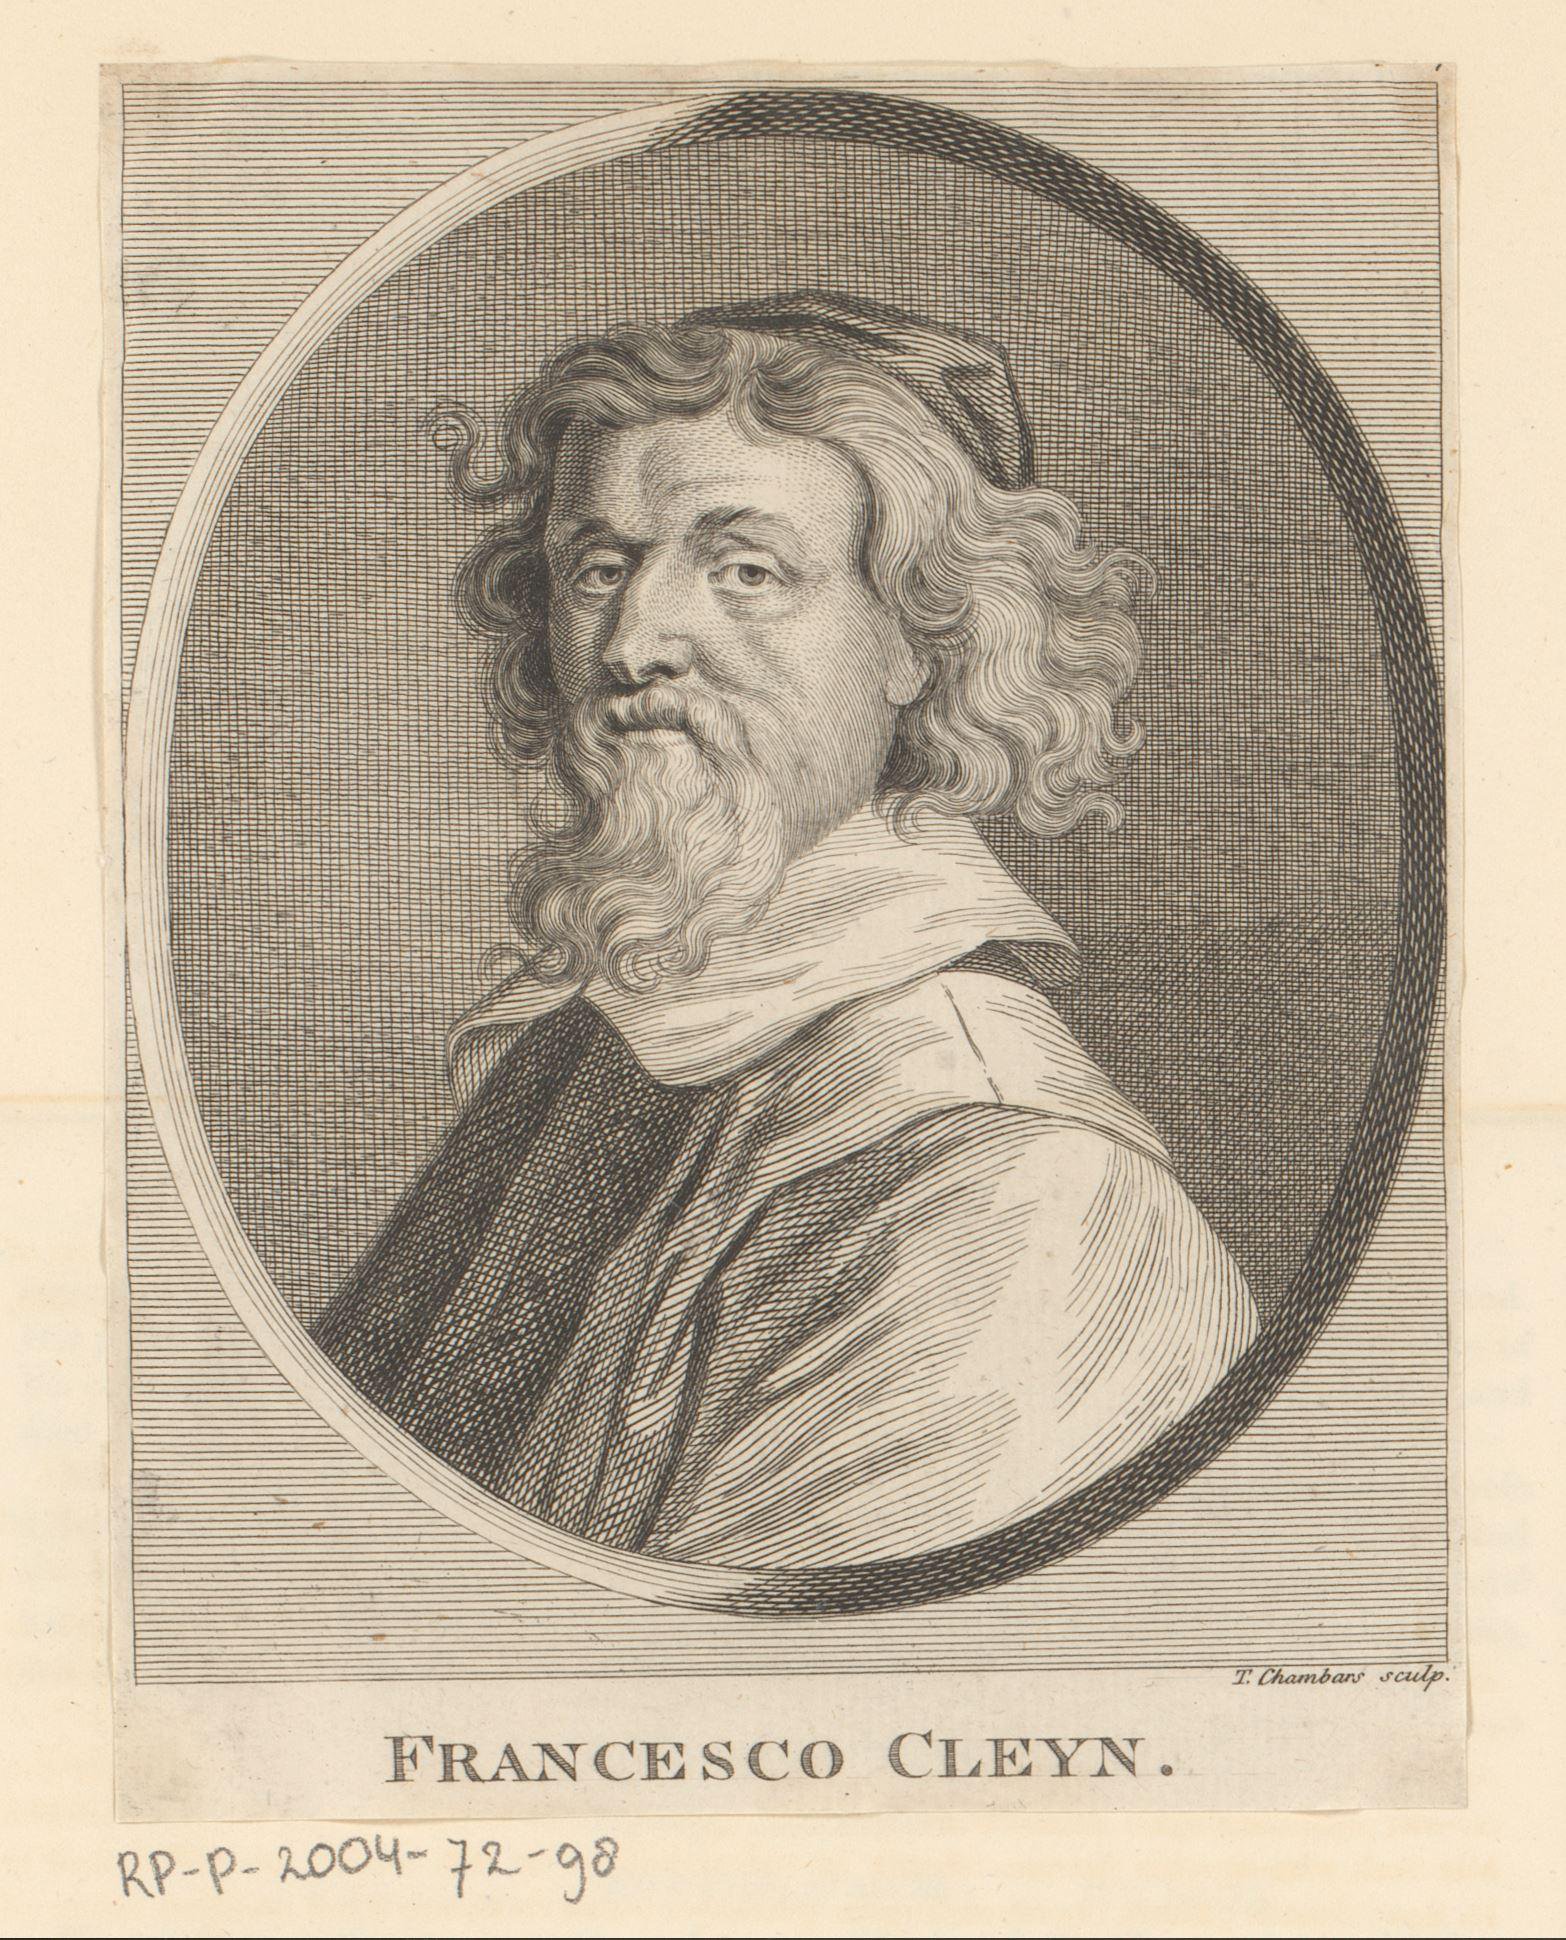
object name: print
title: Portret van Frantz Klein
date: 1762-1789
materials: paper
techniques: engraving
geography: london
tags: london, print maker, franz cleyn, historical persons, portrait, self-portrait of painter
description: Prent uit: Walpole, Horace. Anecdotes of painting in England : with some account of the principal artists : and incidental notes on other arts; collected by the late Mr. George Vertue : and now digested and published from his original Mss. / by Horace Walpole. 4 dln. Londen: Horace Walpole, 1762-1789, dl. 2, p. 127. De samensteller heeft deze prent in het album geplakt als illustratie bij: Pilkington, Matthew en Johann Heinrich Füssli. A dictionary of painters, from the revival of the art to the present period. 4 dln. Londen: John Crowder, 1805, dl. 1, p. 123.